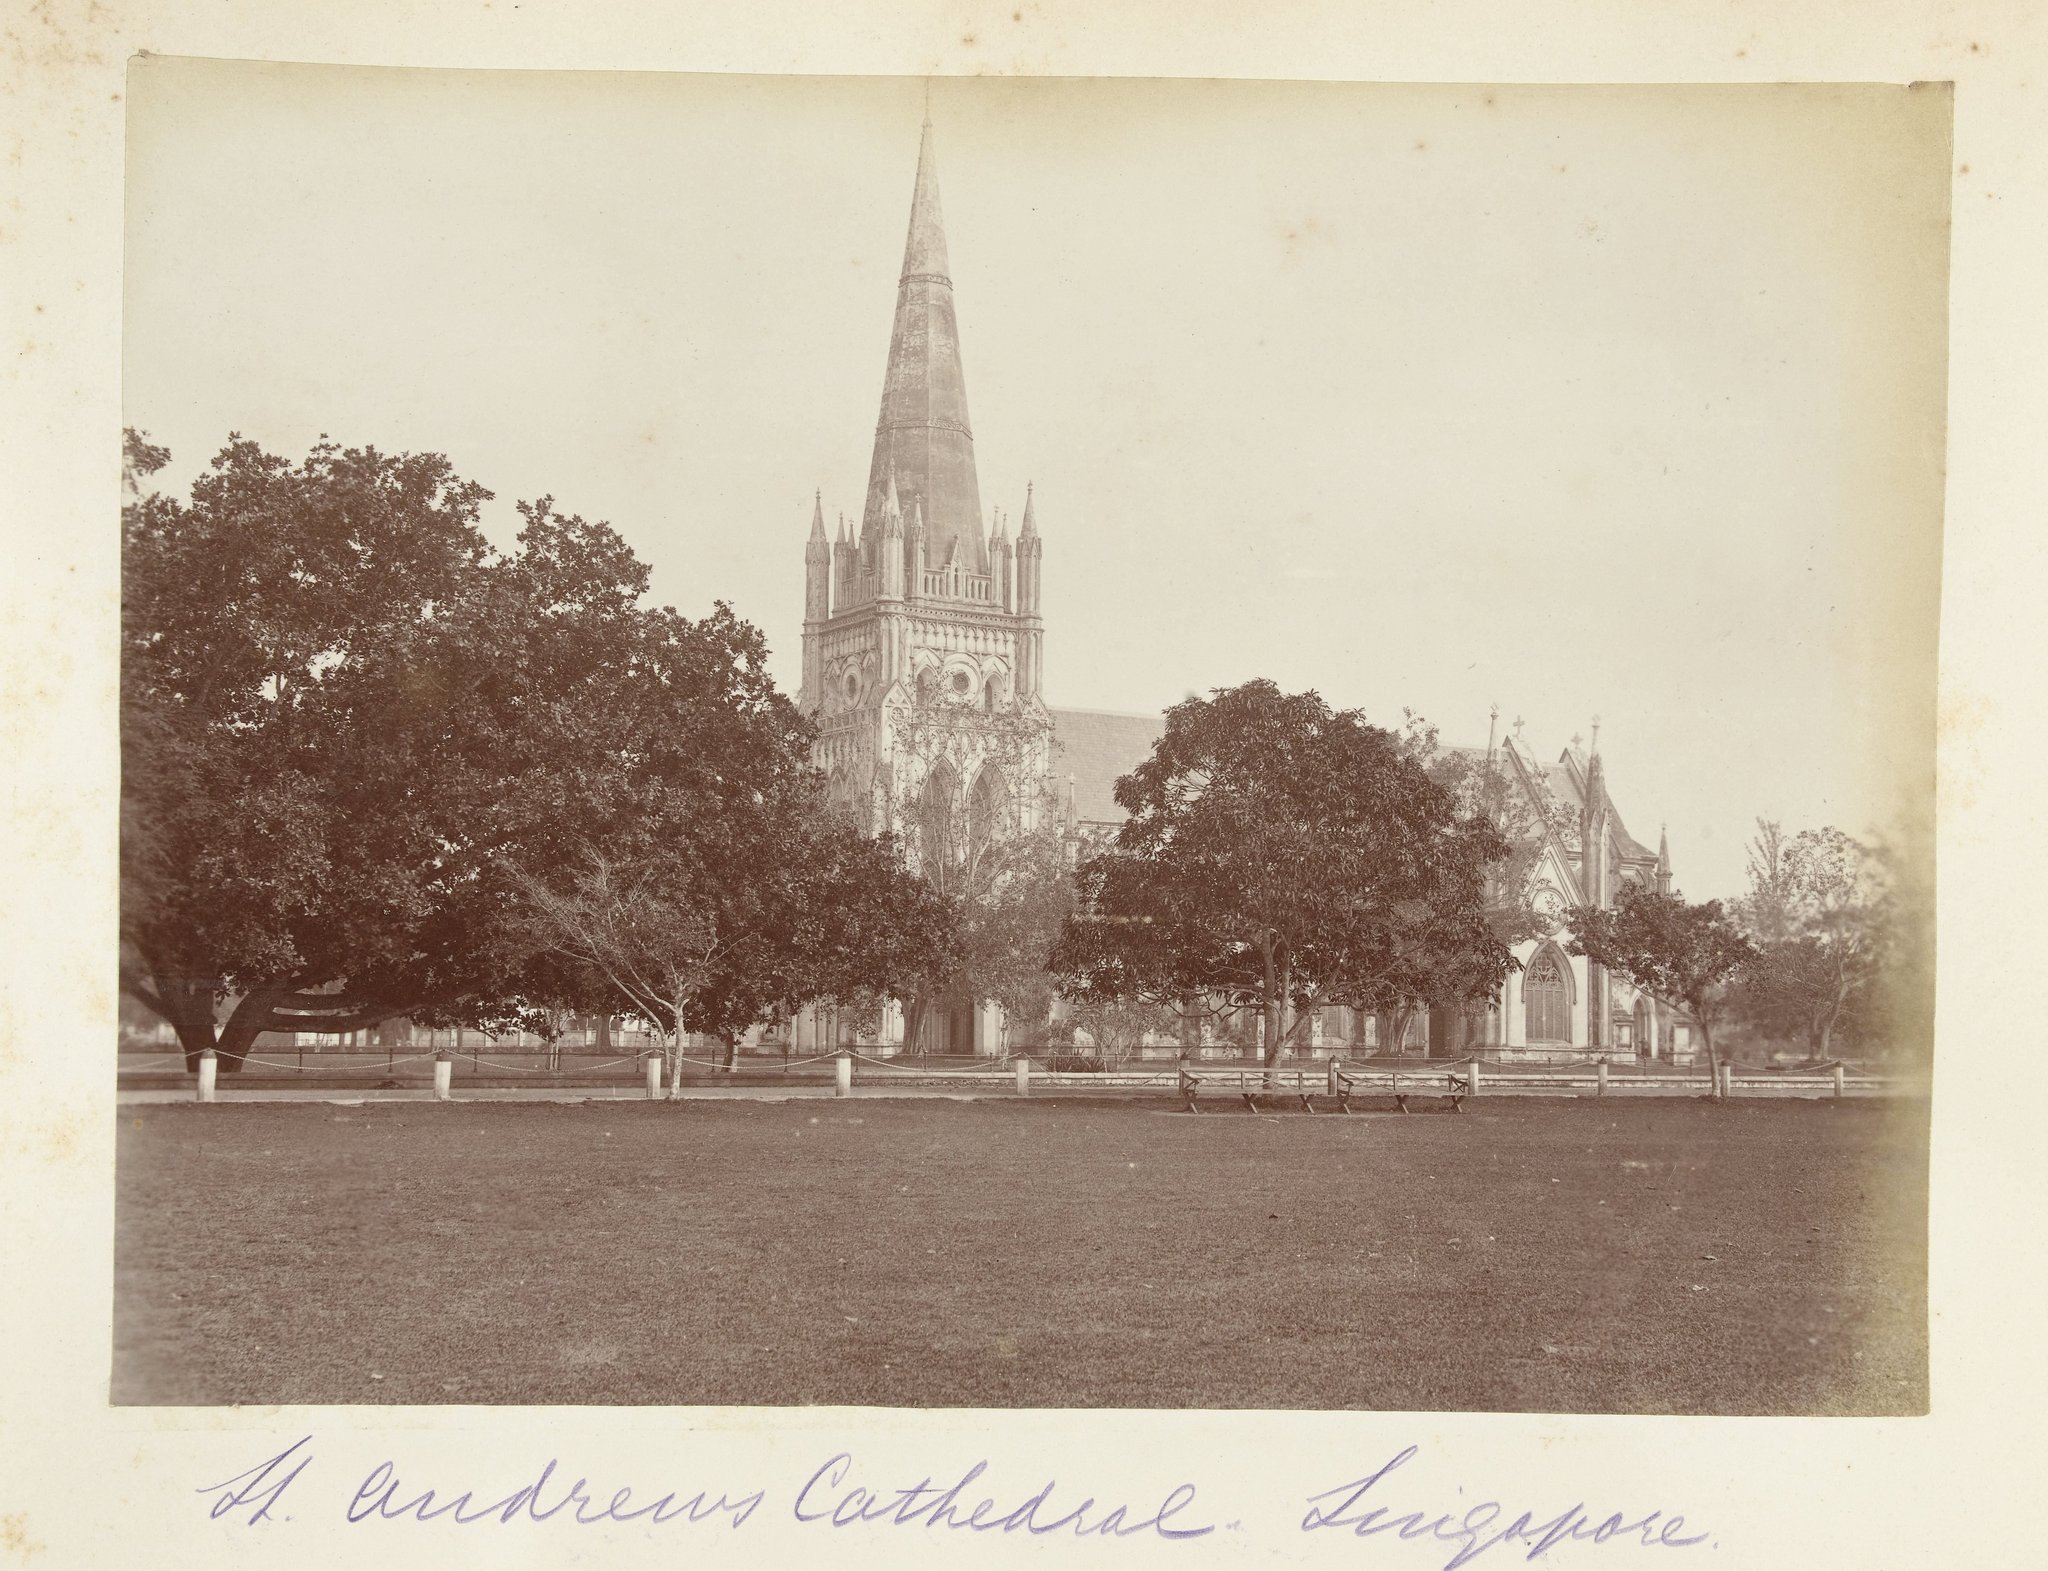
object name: photograph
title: St Andrews Cathedral Singapore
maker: Anonymous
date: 1890-1910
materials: cardboard, paper, photographic support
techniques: gelatin silver print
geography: singapore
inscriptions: caption